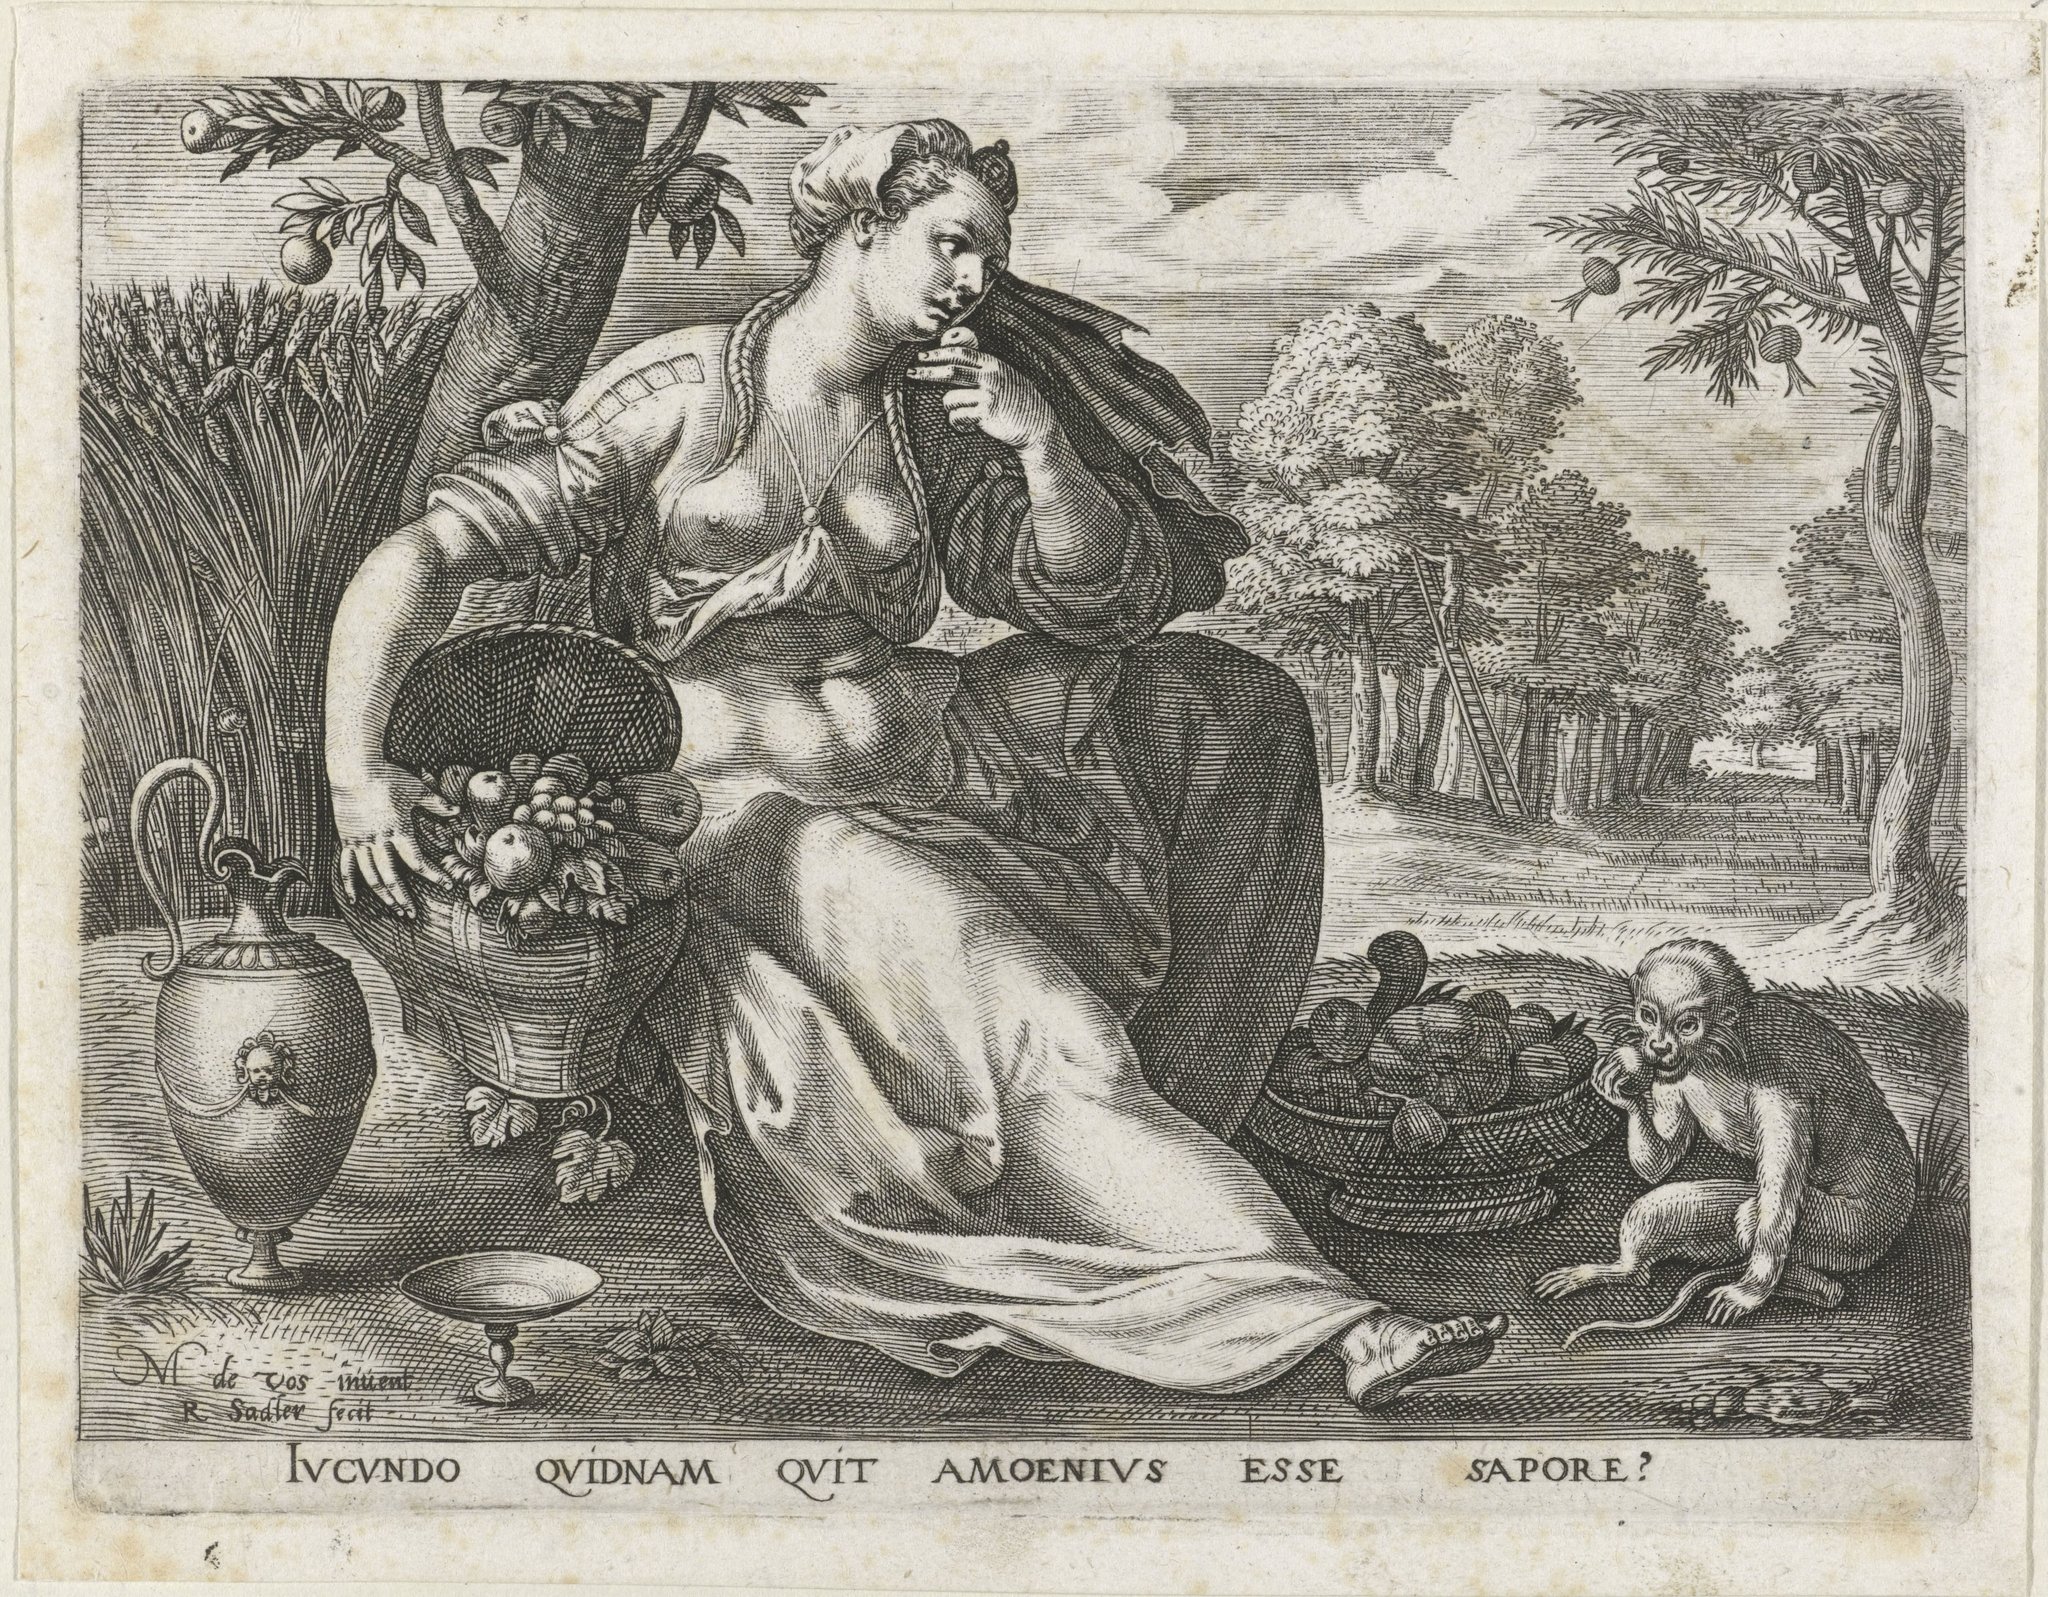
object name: print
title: De vijf zintuigen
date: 1581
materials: paper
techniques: engraving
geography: antwerp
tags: monkeys, apes, fruit, container made of plant material other than wood: basket, taste, tasting (one of the five senses) - aa - female human figure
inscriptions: collector's mark: Lugt 240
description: De vrouwelijke personificatie van de Smaak zit op de grond onder een boom. Naast haar een mand met fruit, waarvan zij een vrucht proeft, Rechtsonder zit een aap. Ook hij proeft een vrucht. De prent heeft een Latijns onderschrift en is deel van een vijfdelige serie over de zintuigen.